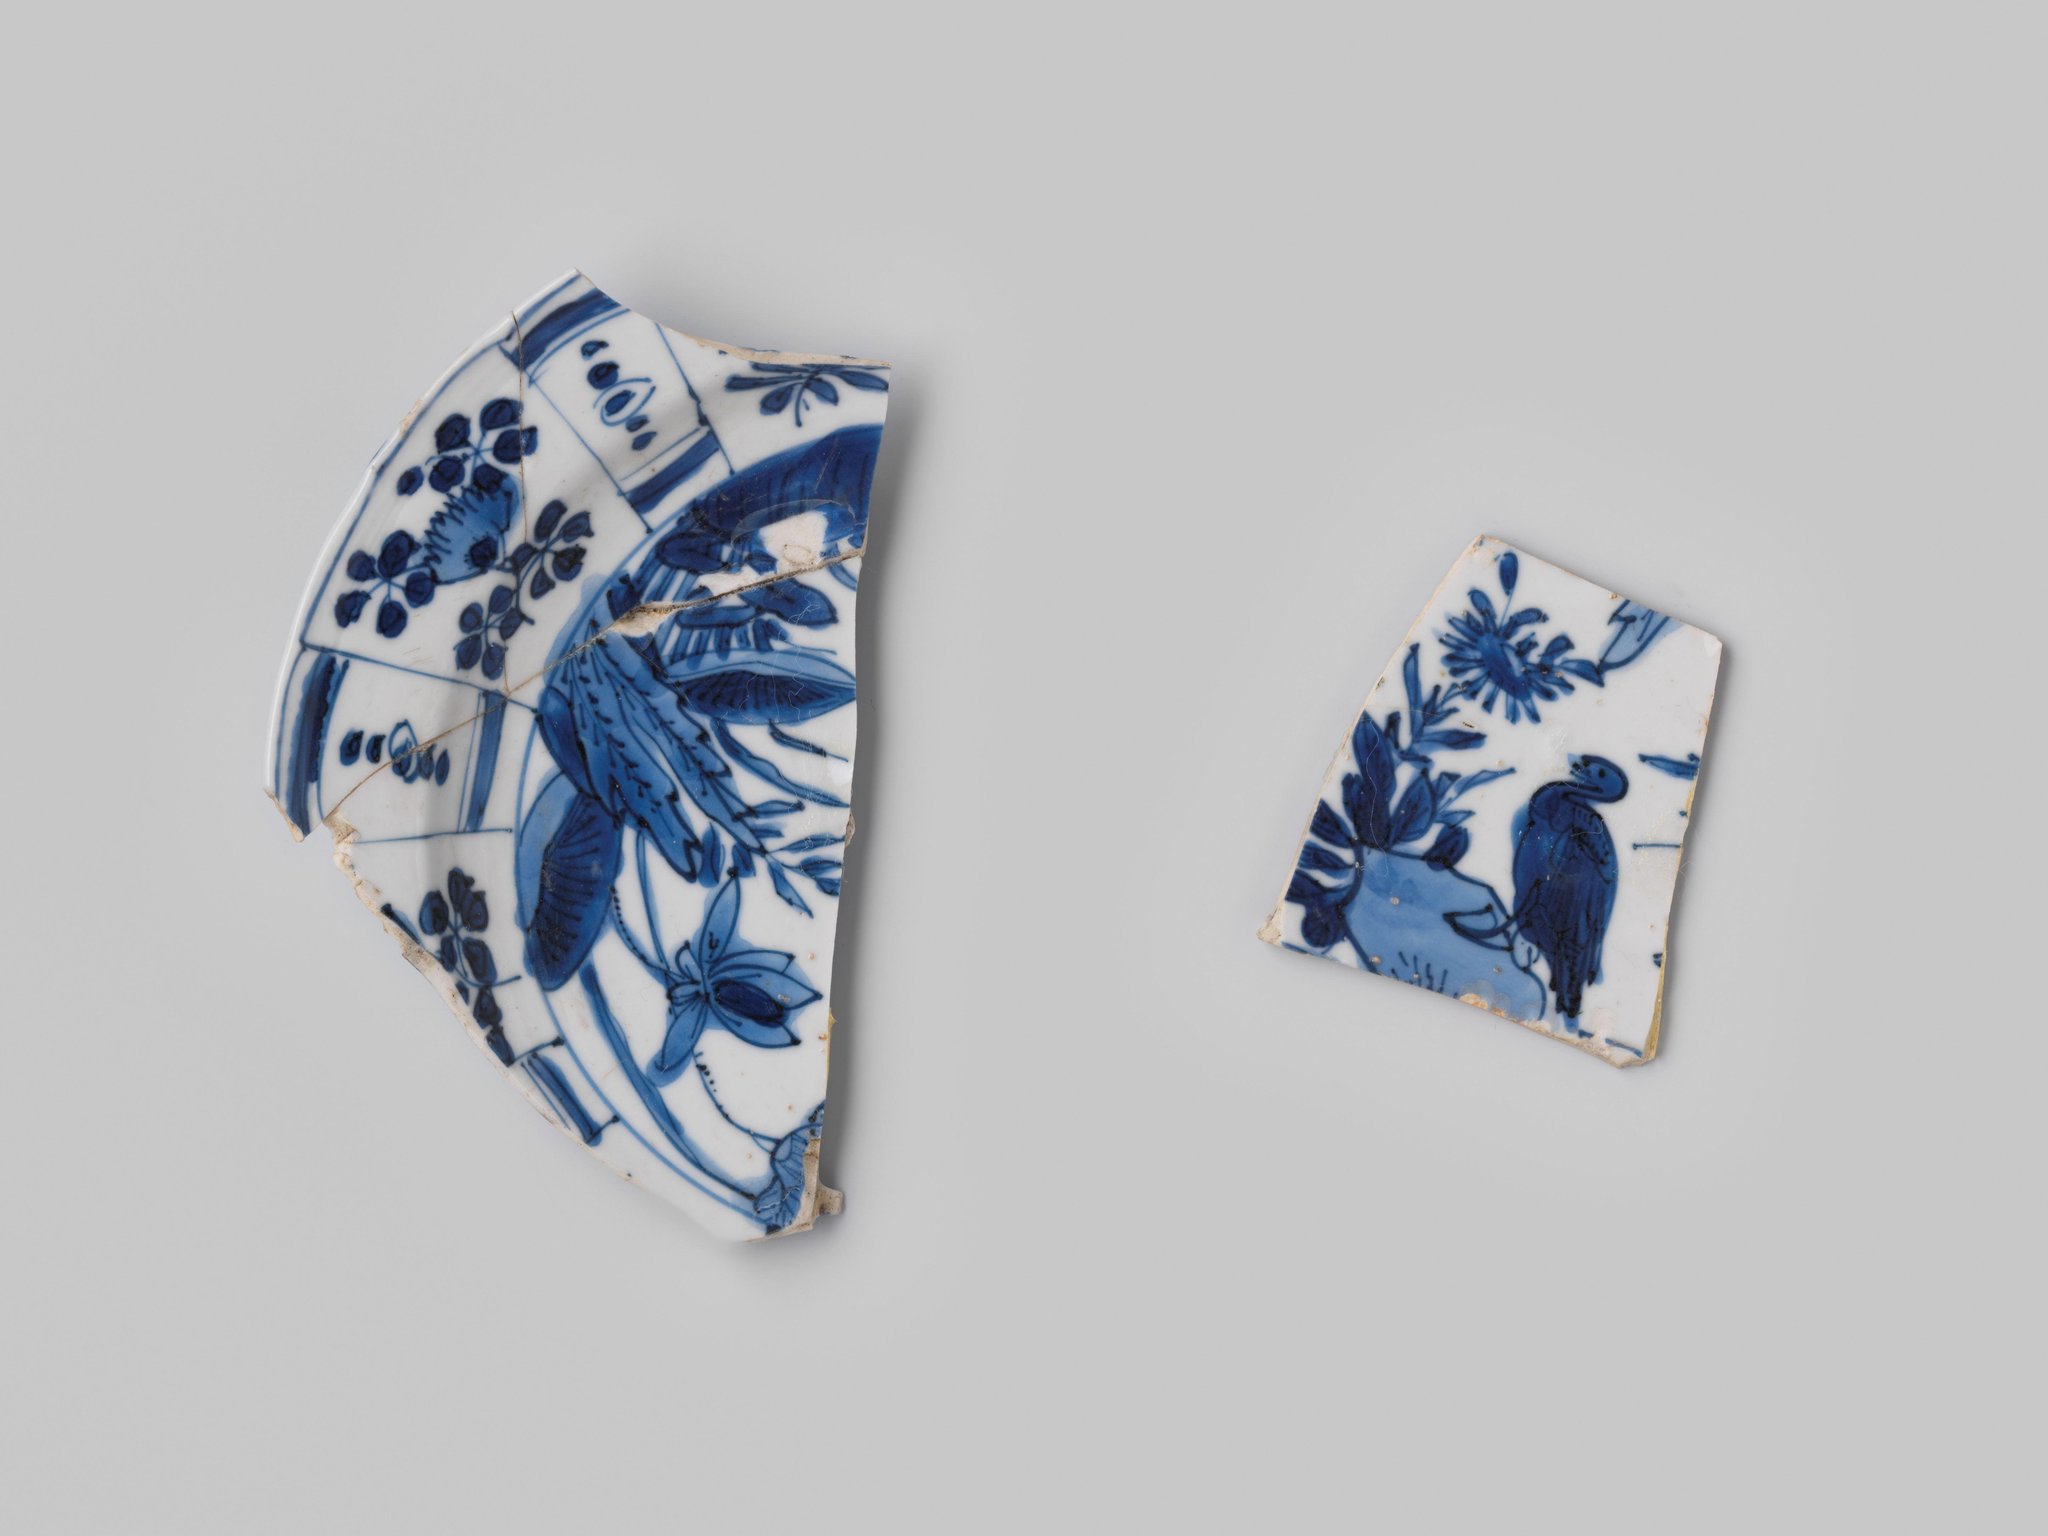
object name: plate dish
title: Scherven van een bord uit V.O.C.-schip de 'Witte Leeuw'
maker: Anonymous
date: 1613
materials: bone china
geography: jingdezhen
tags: verenigde oostindische compagnie, sint-helena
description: A saucer with a flattened rim. A saucer with a flattened rim. A central decoration of a waterfowl and a lotus. Panels decorated with flowers. N.B. This piece has no moulded relief.